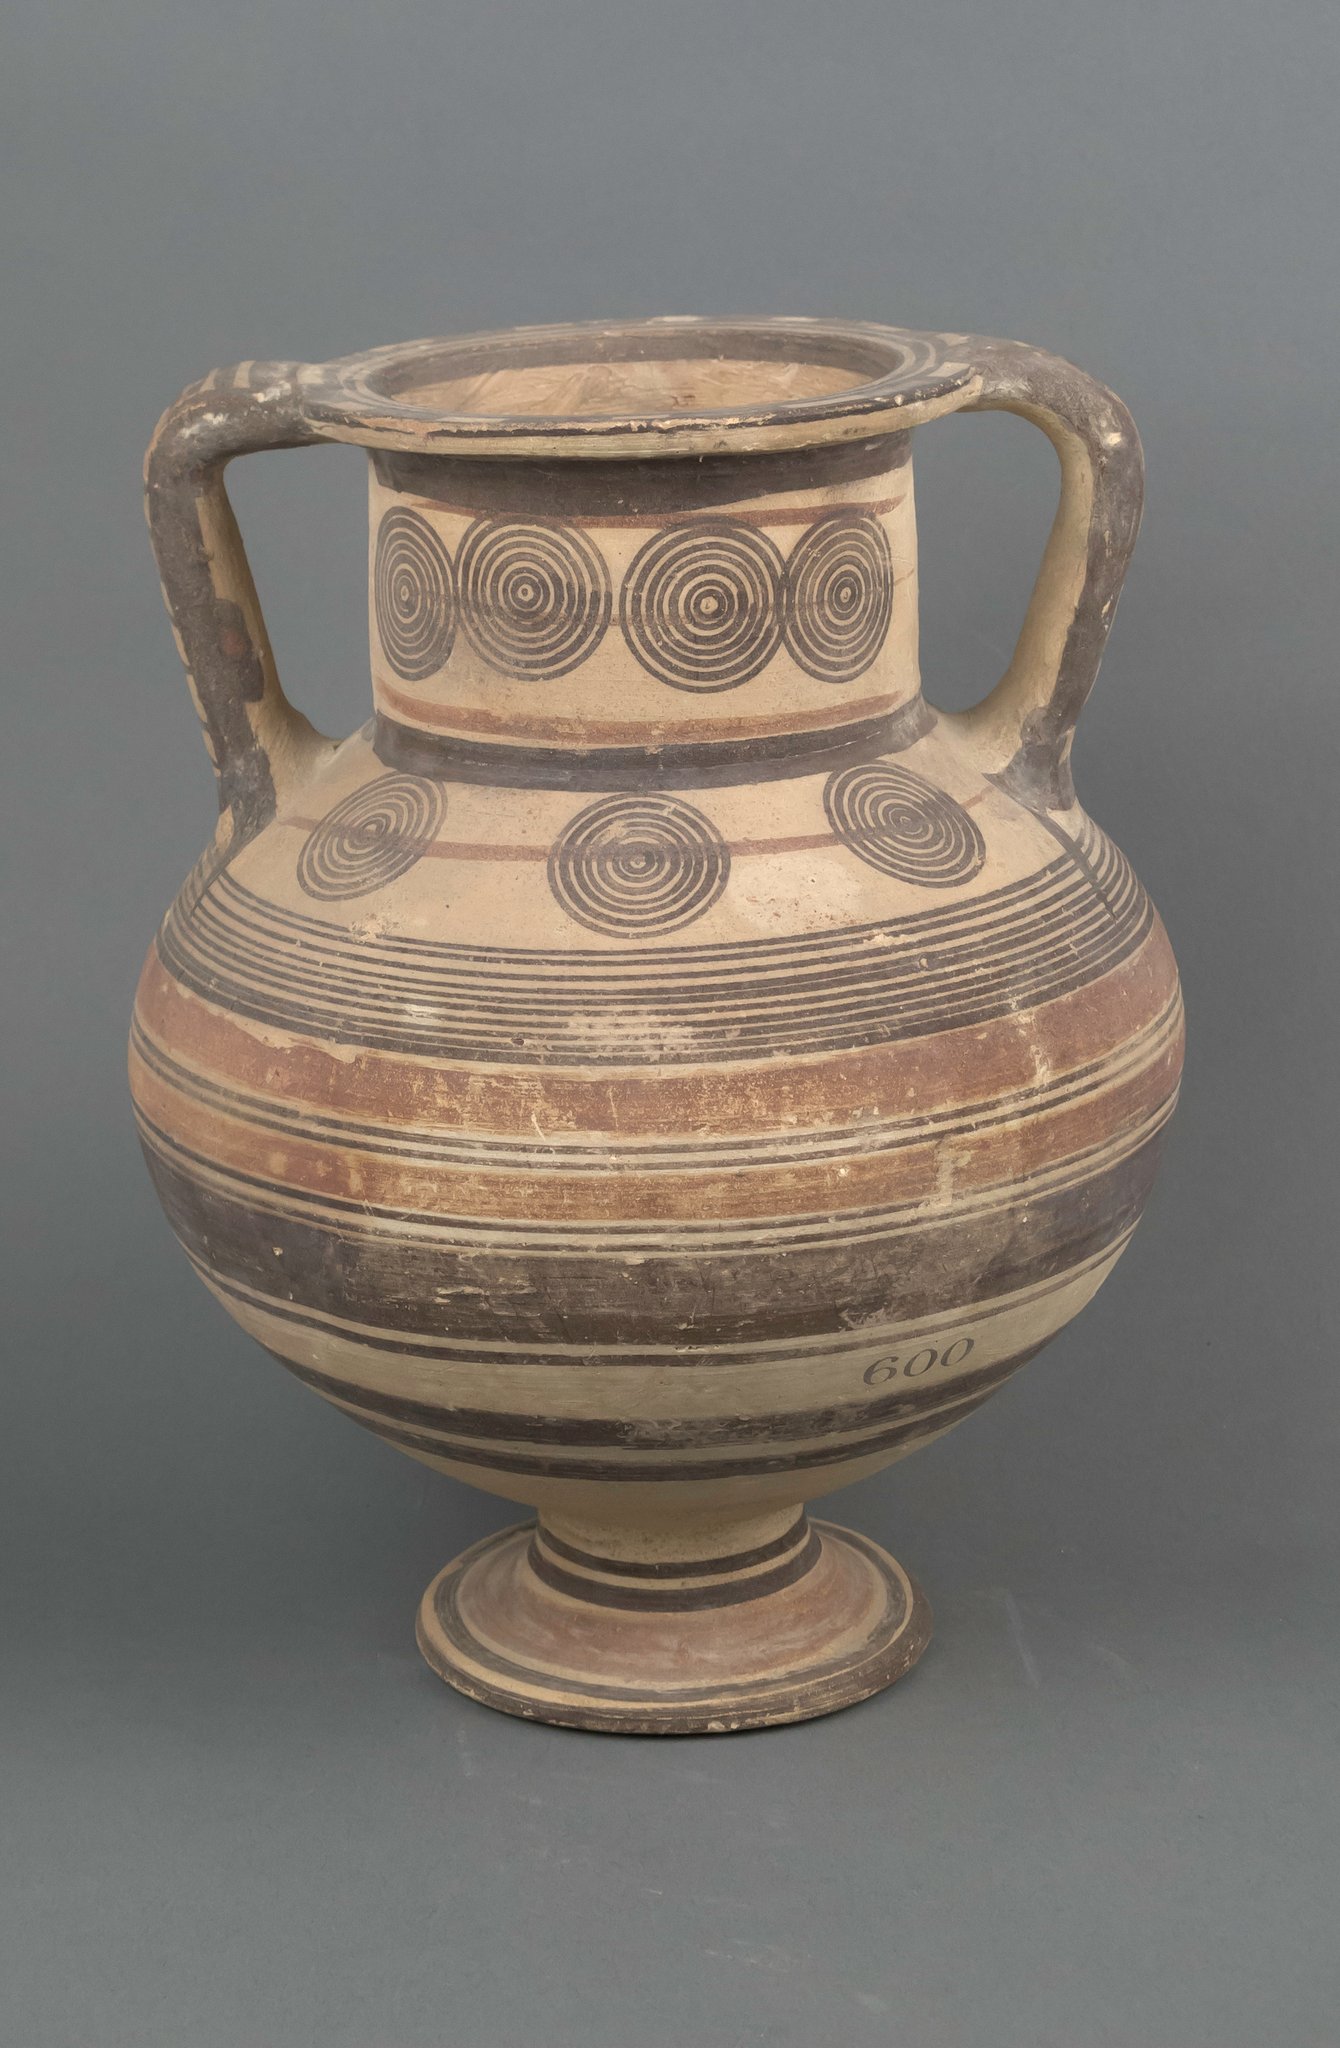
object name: amphoriskos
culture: cypriot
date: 750-600 BCE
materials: terracotta